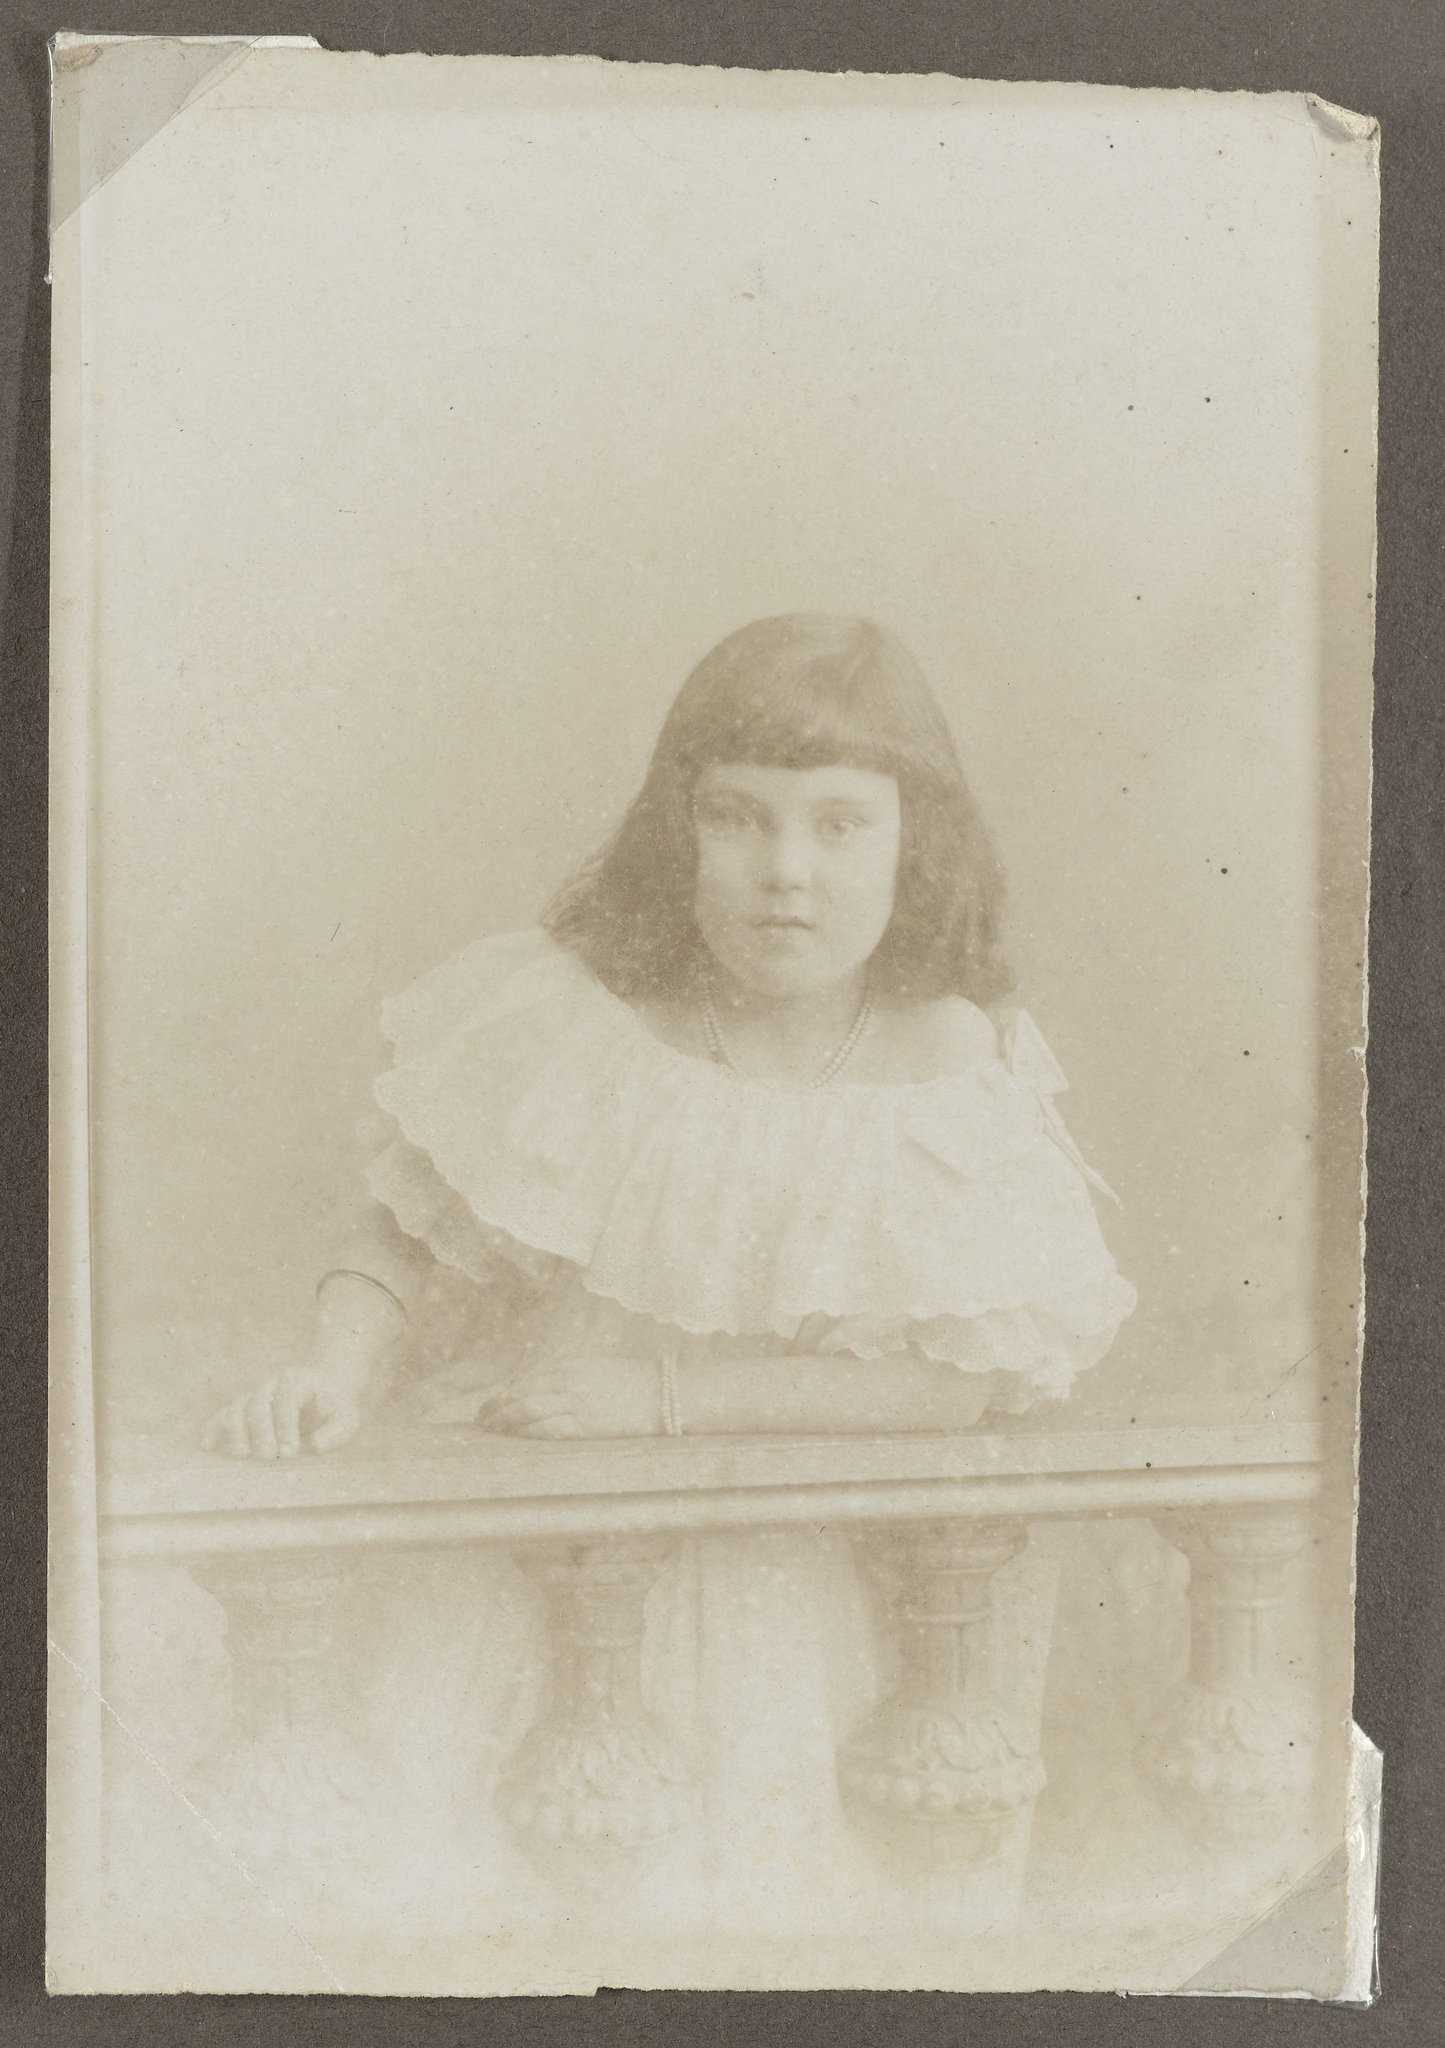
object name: carte de visite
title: Portret van Tine bij een balustrade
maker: cornelis johannes lodewicus vermeulen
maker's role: fotograaf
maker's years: 1861-1936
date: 1890-1910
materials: paper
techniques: collodion silver print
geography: amsterdam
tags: historical persons, girl (child between toddler and youth)